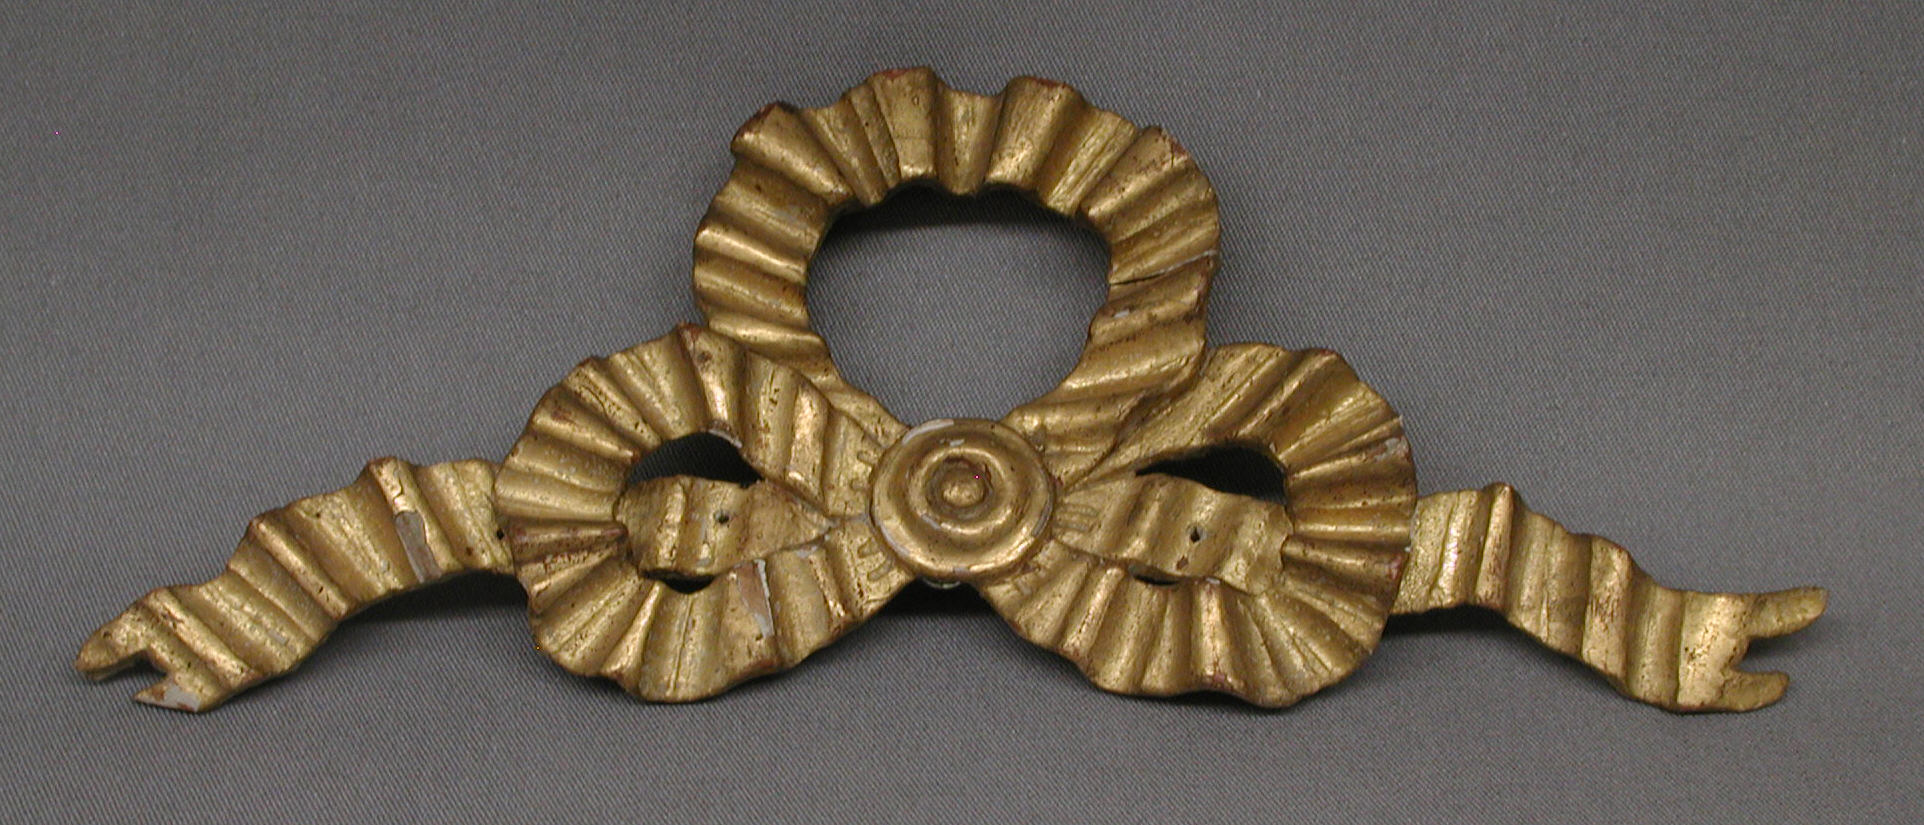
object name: knot of ribbon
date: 1701-1800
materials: gilt, wood